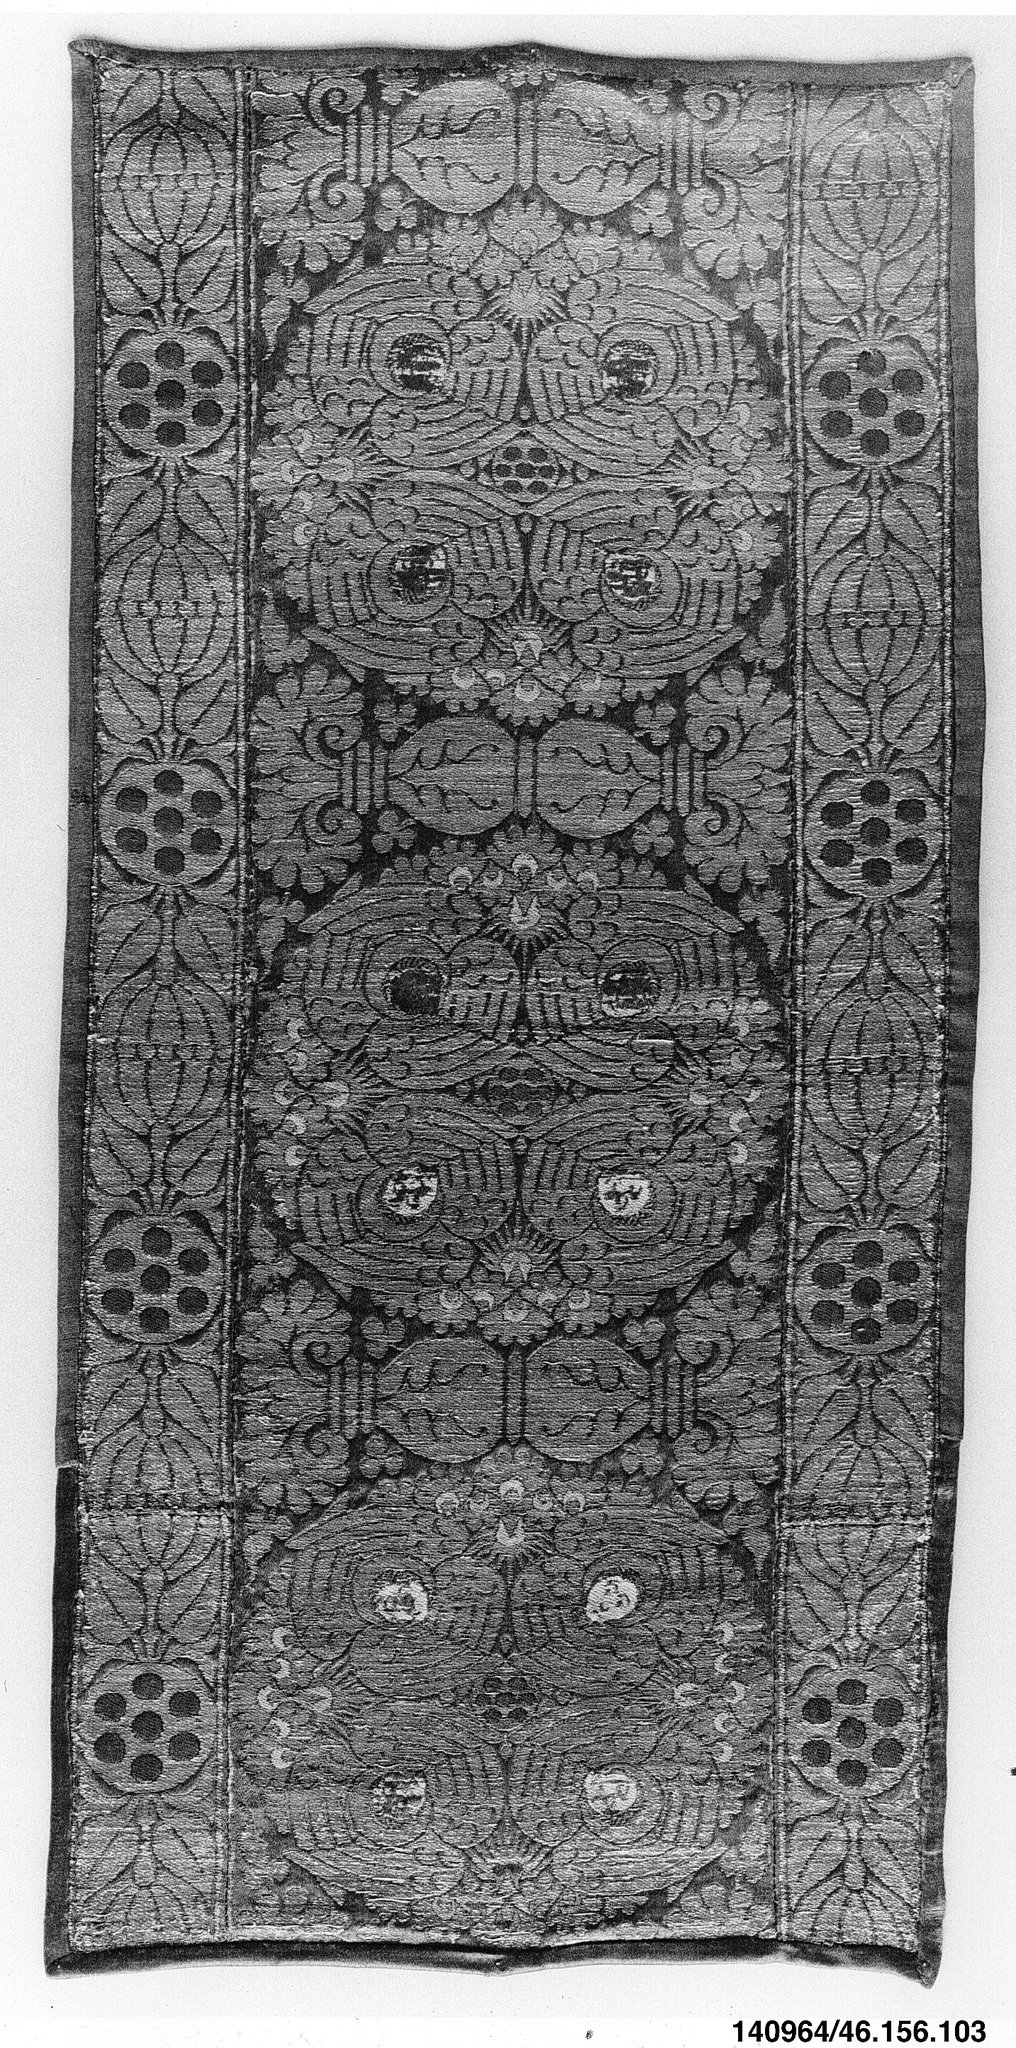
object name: orphrey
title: Fragment of an orphrey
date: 1451-1500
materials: metal thread, silk